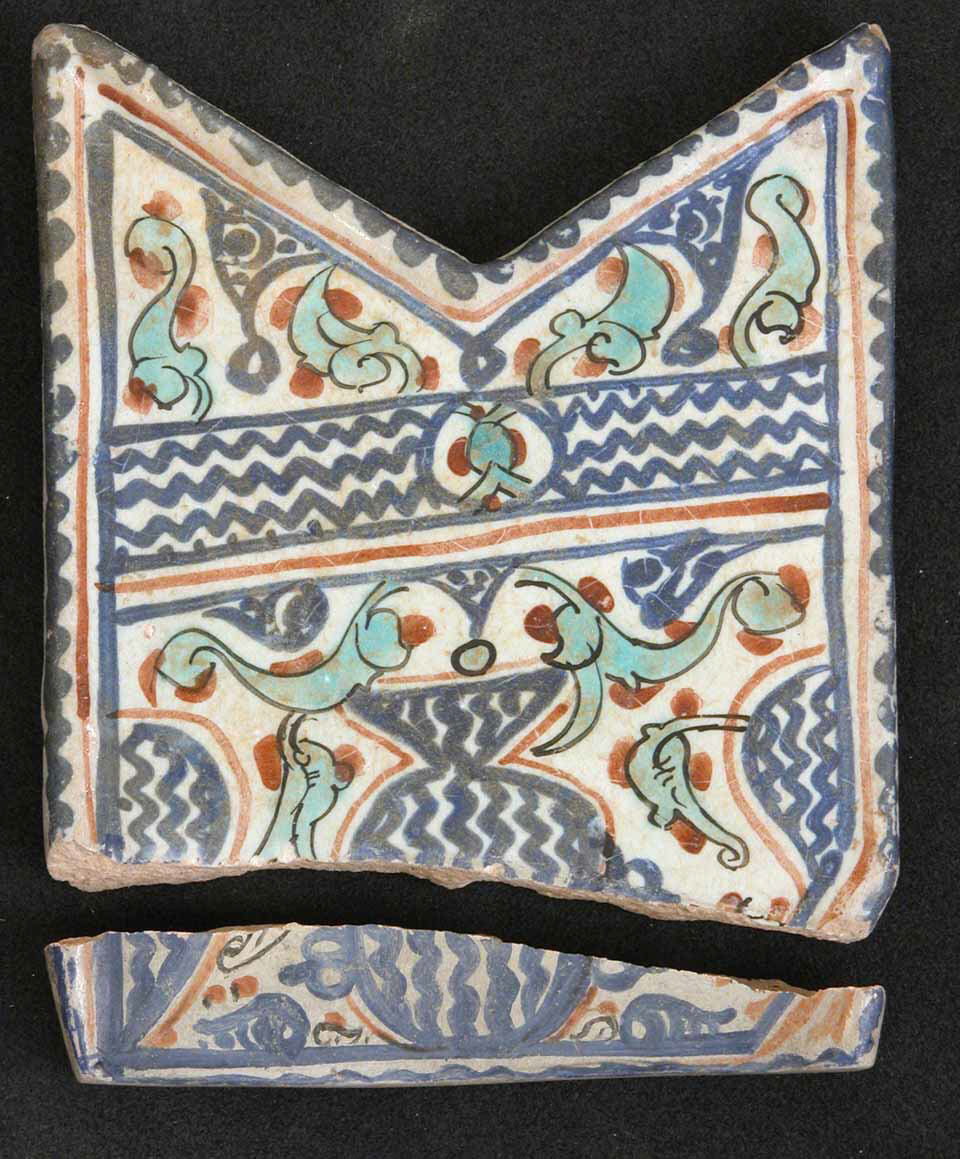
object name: fragmentary tile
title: Fragmentary Tile, Probably Arrow-Shaped in Origin, and Modern Filling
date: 1167-1300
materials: glaze, stonepaste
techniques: overglaze, painting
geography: iran